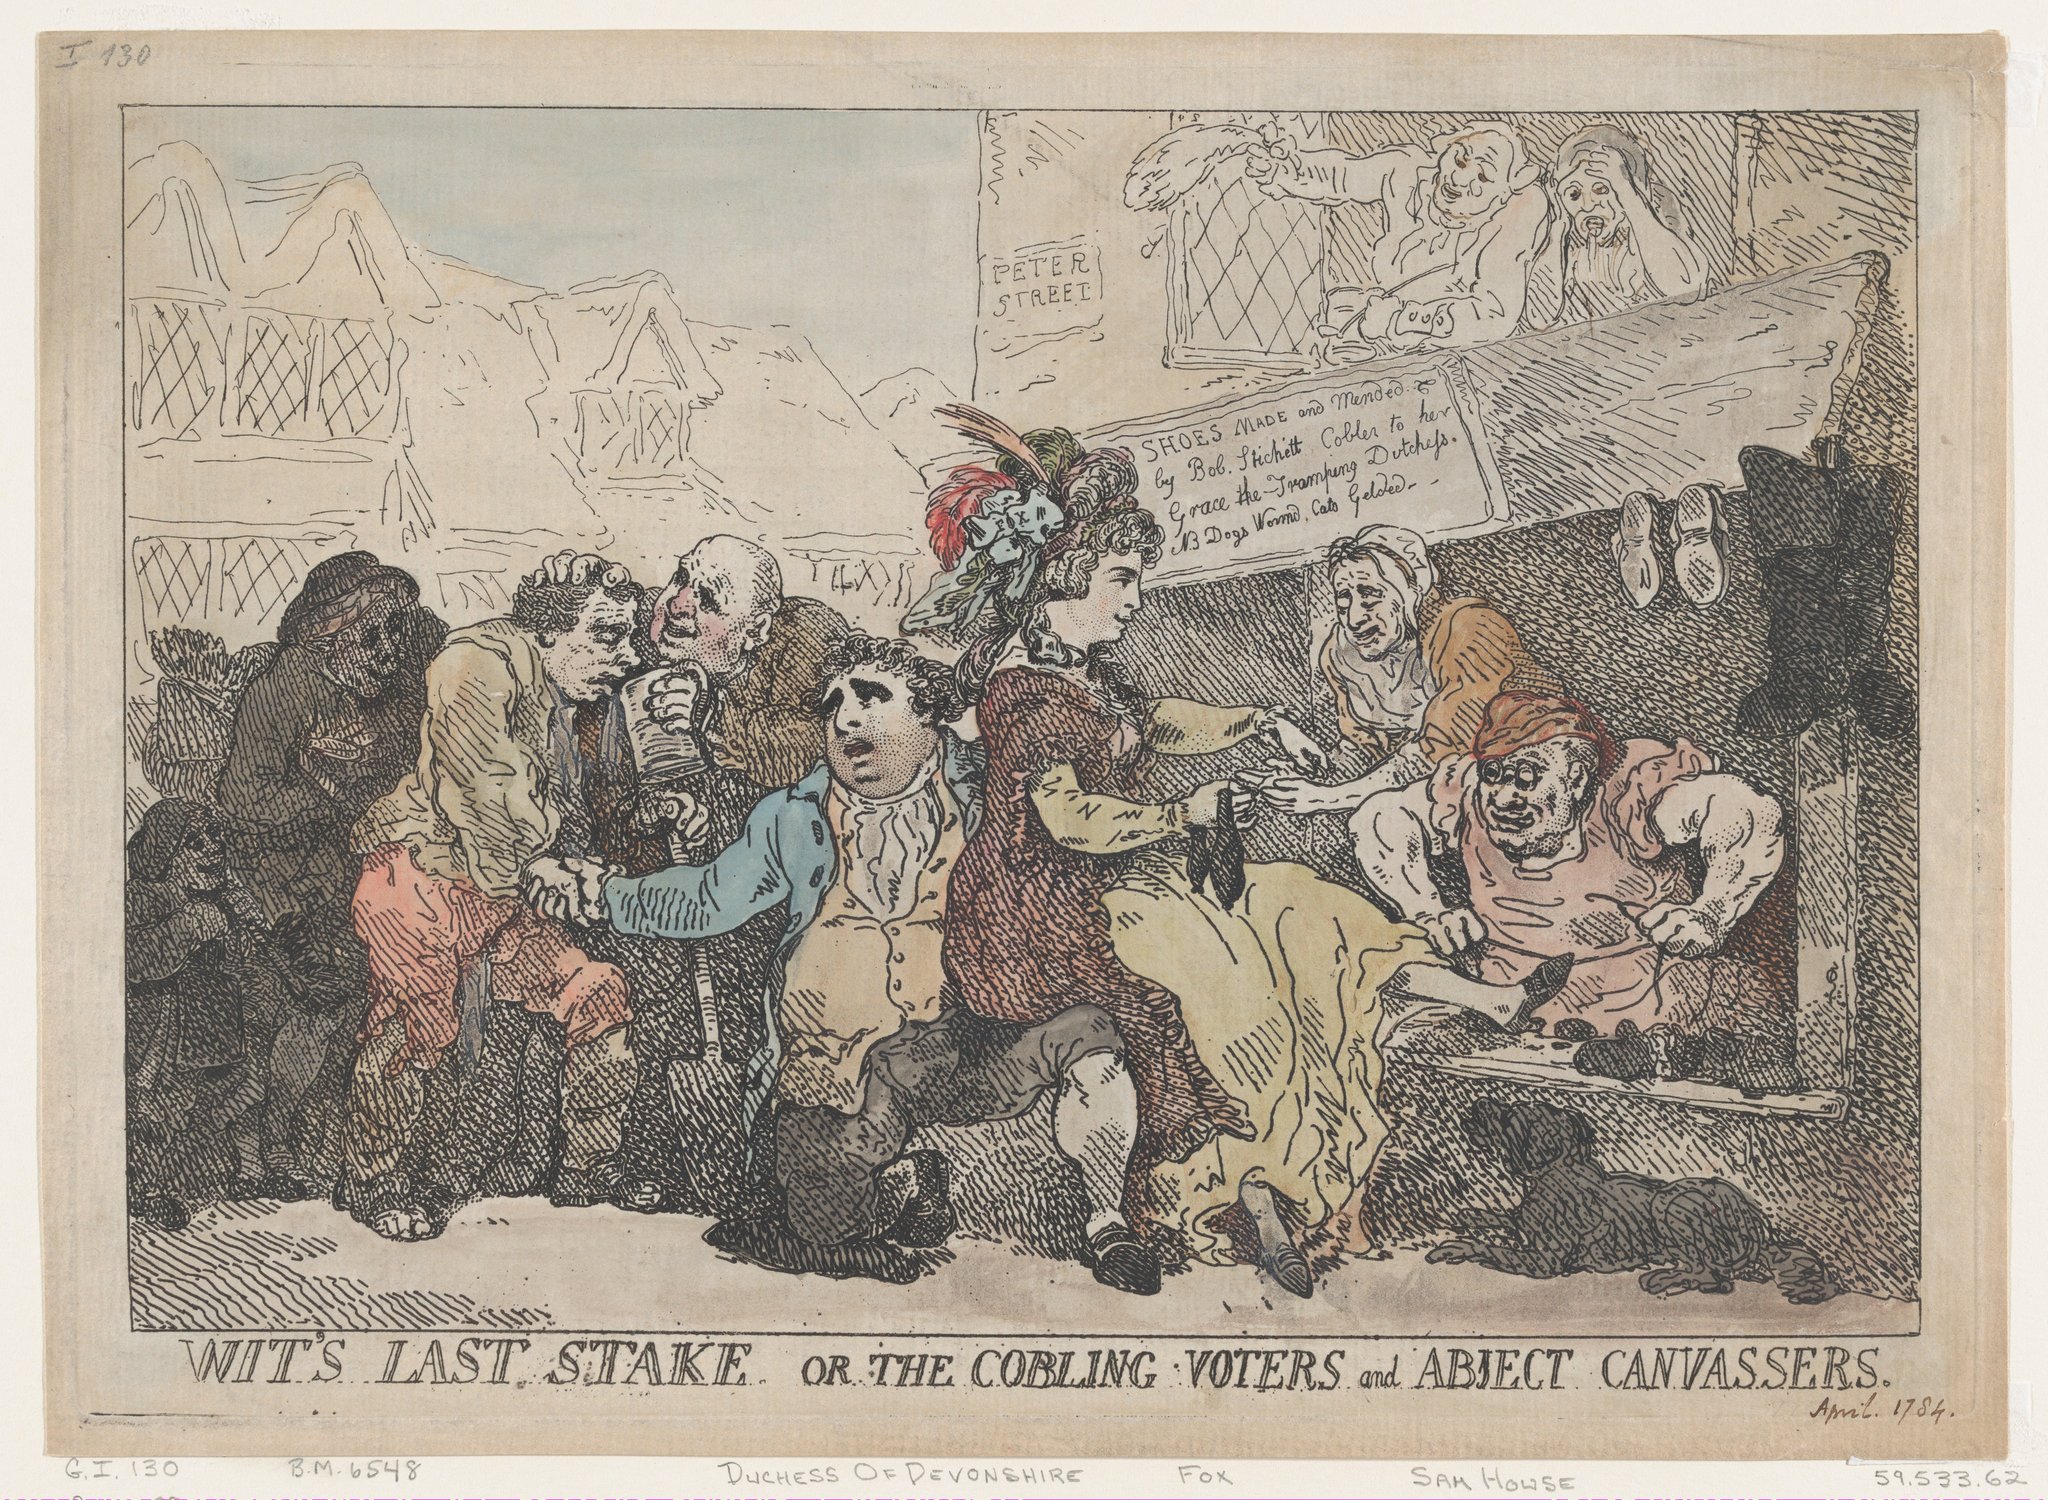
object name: print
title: Wit's Last Stake, or the Cobbling Voters and Abject Canvassers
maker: thomas rowlandson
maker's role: artist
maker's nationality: british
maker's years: 1757-1827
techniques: etching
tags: satire,men,women,politics